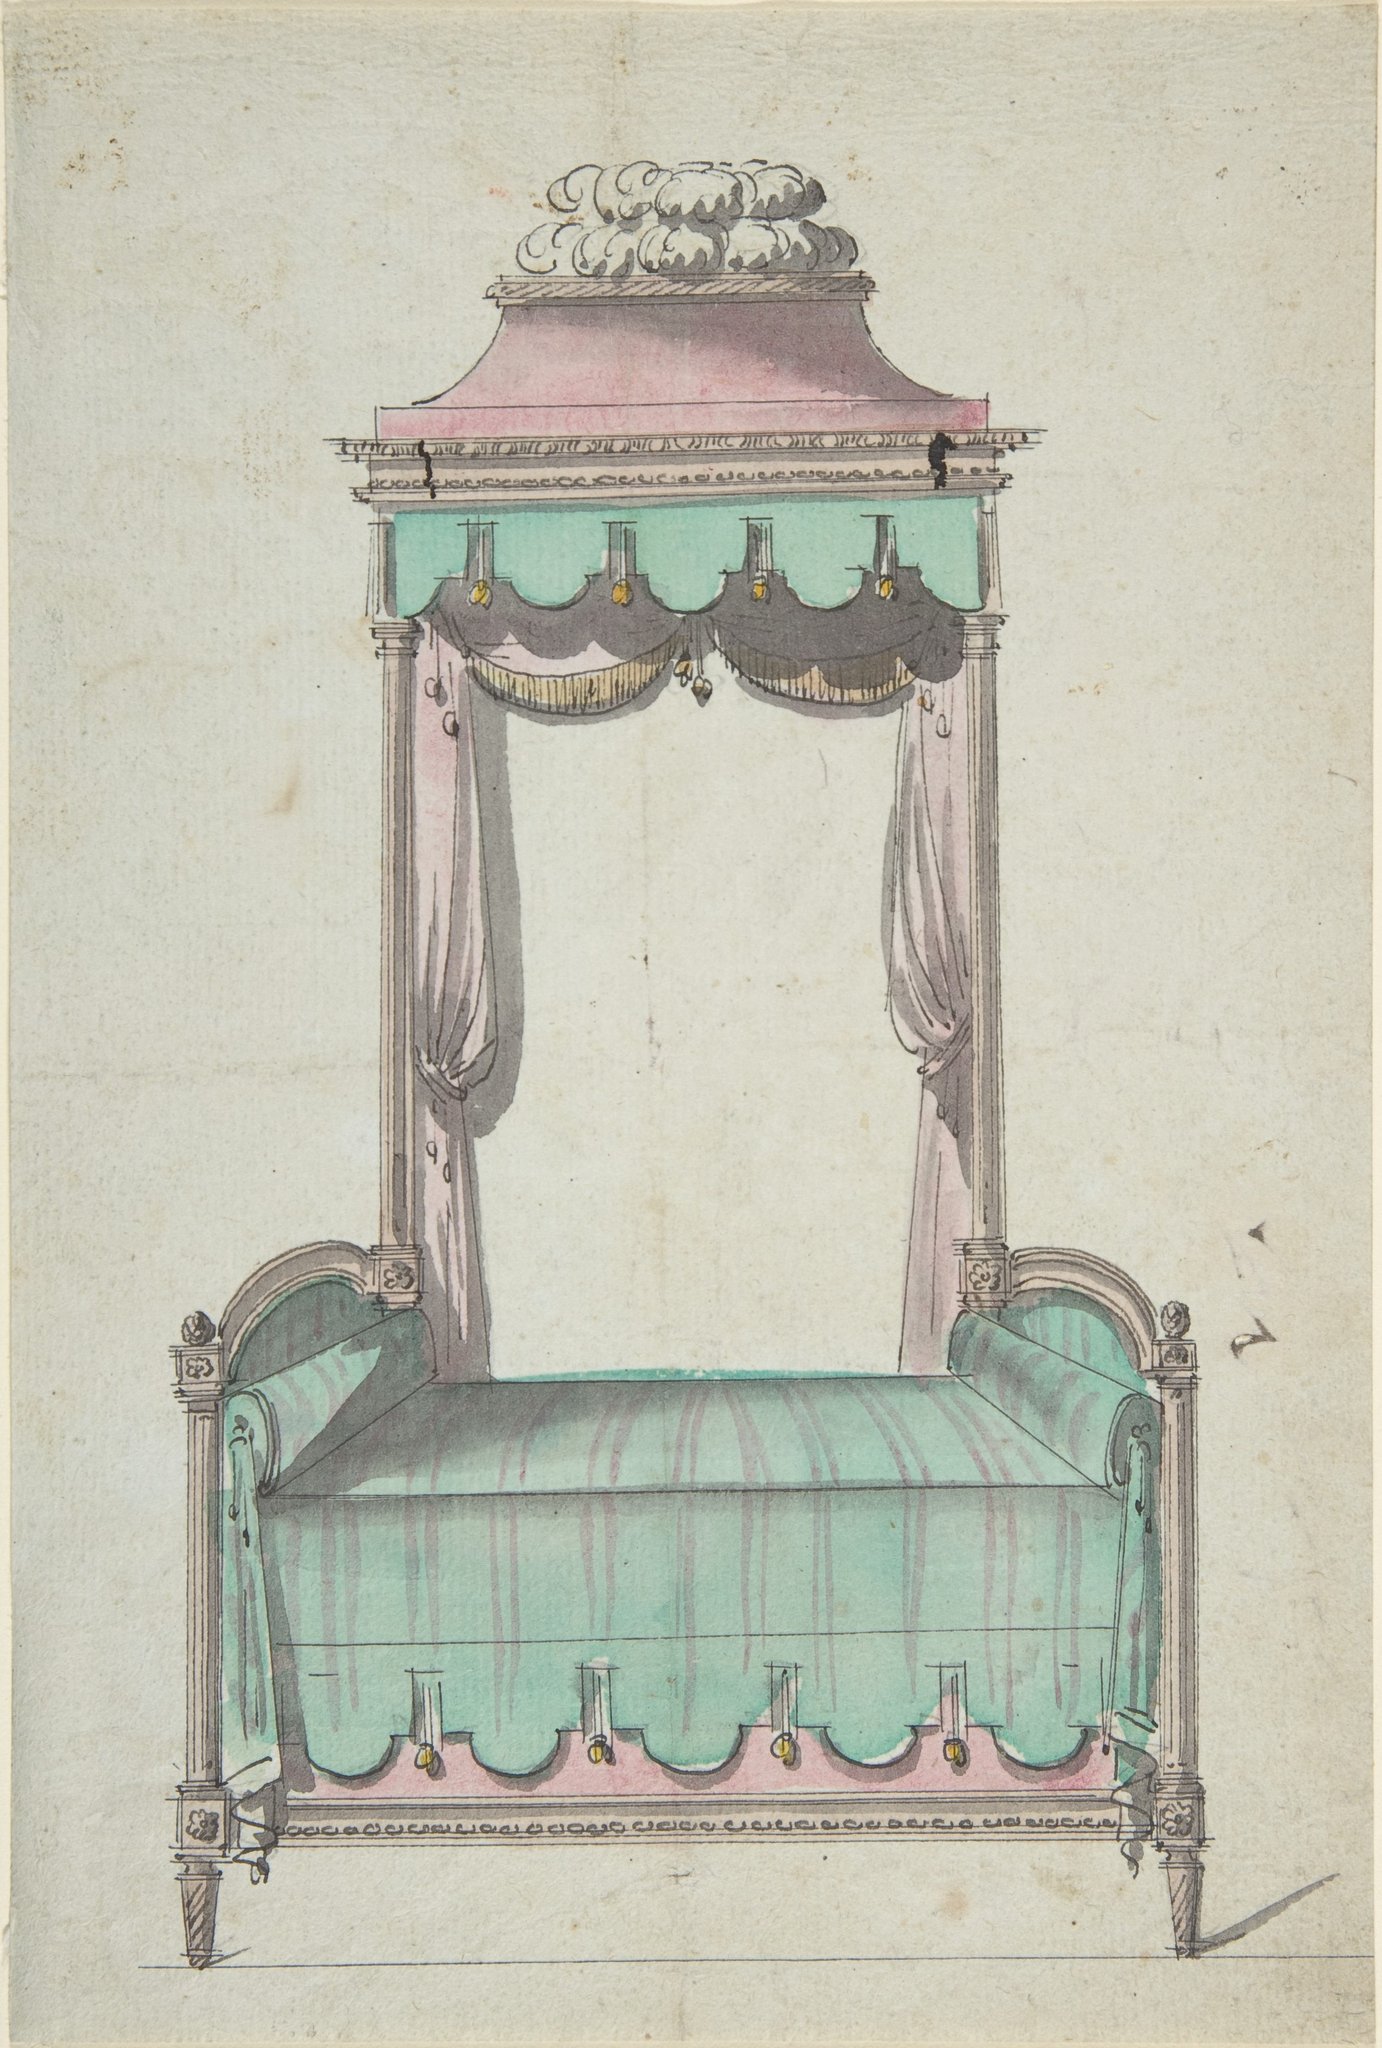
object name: drawing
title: Design for a Bed and a Canopy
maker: anonymous, french, 18th century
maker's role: artist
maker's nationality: french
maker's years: 1700-1800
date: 1701-1800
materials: ink, watercolor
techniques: brush, pen, wash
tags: beds